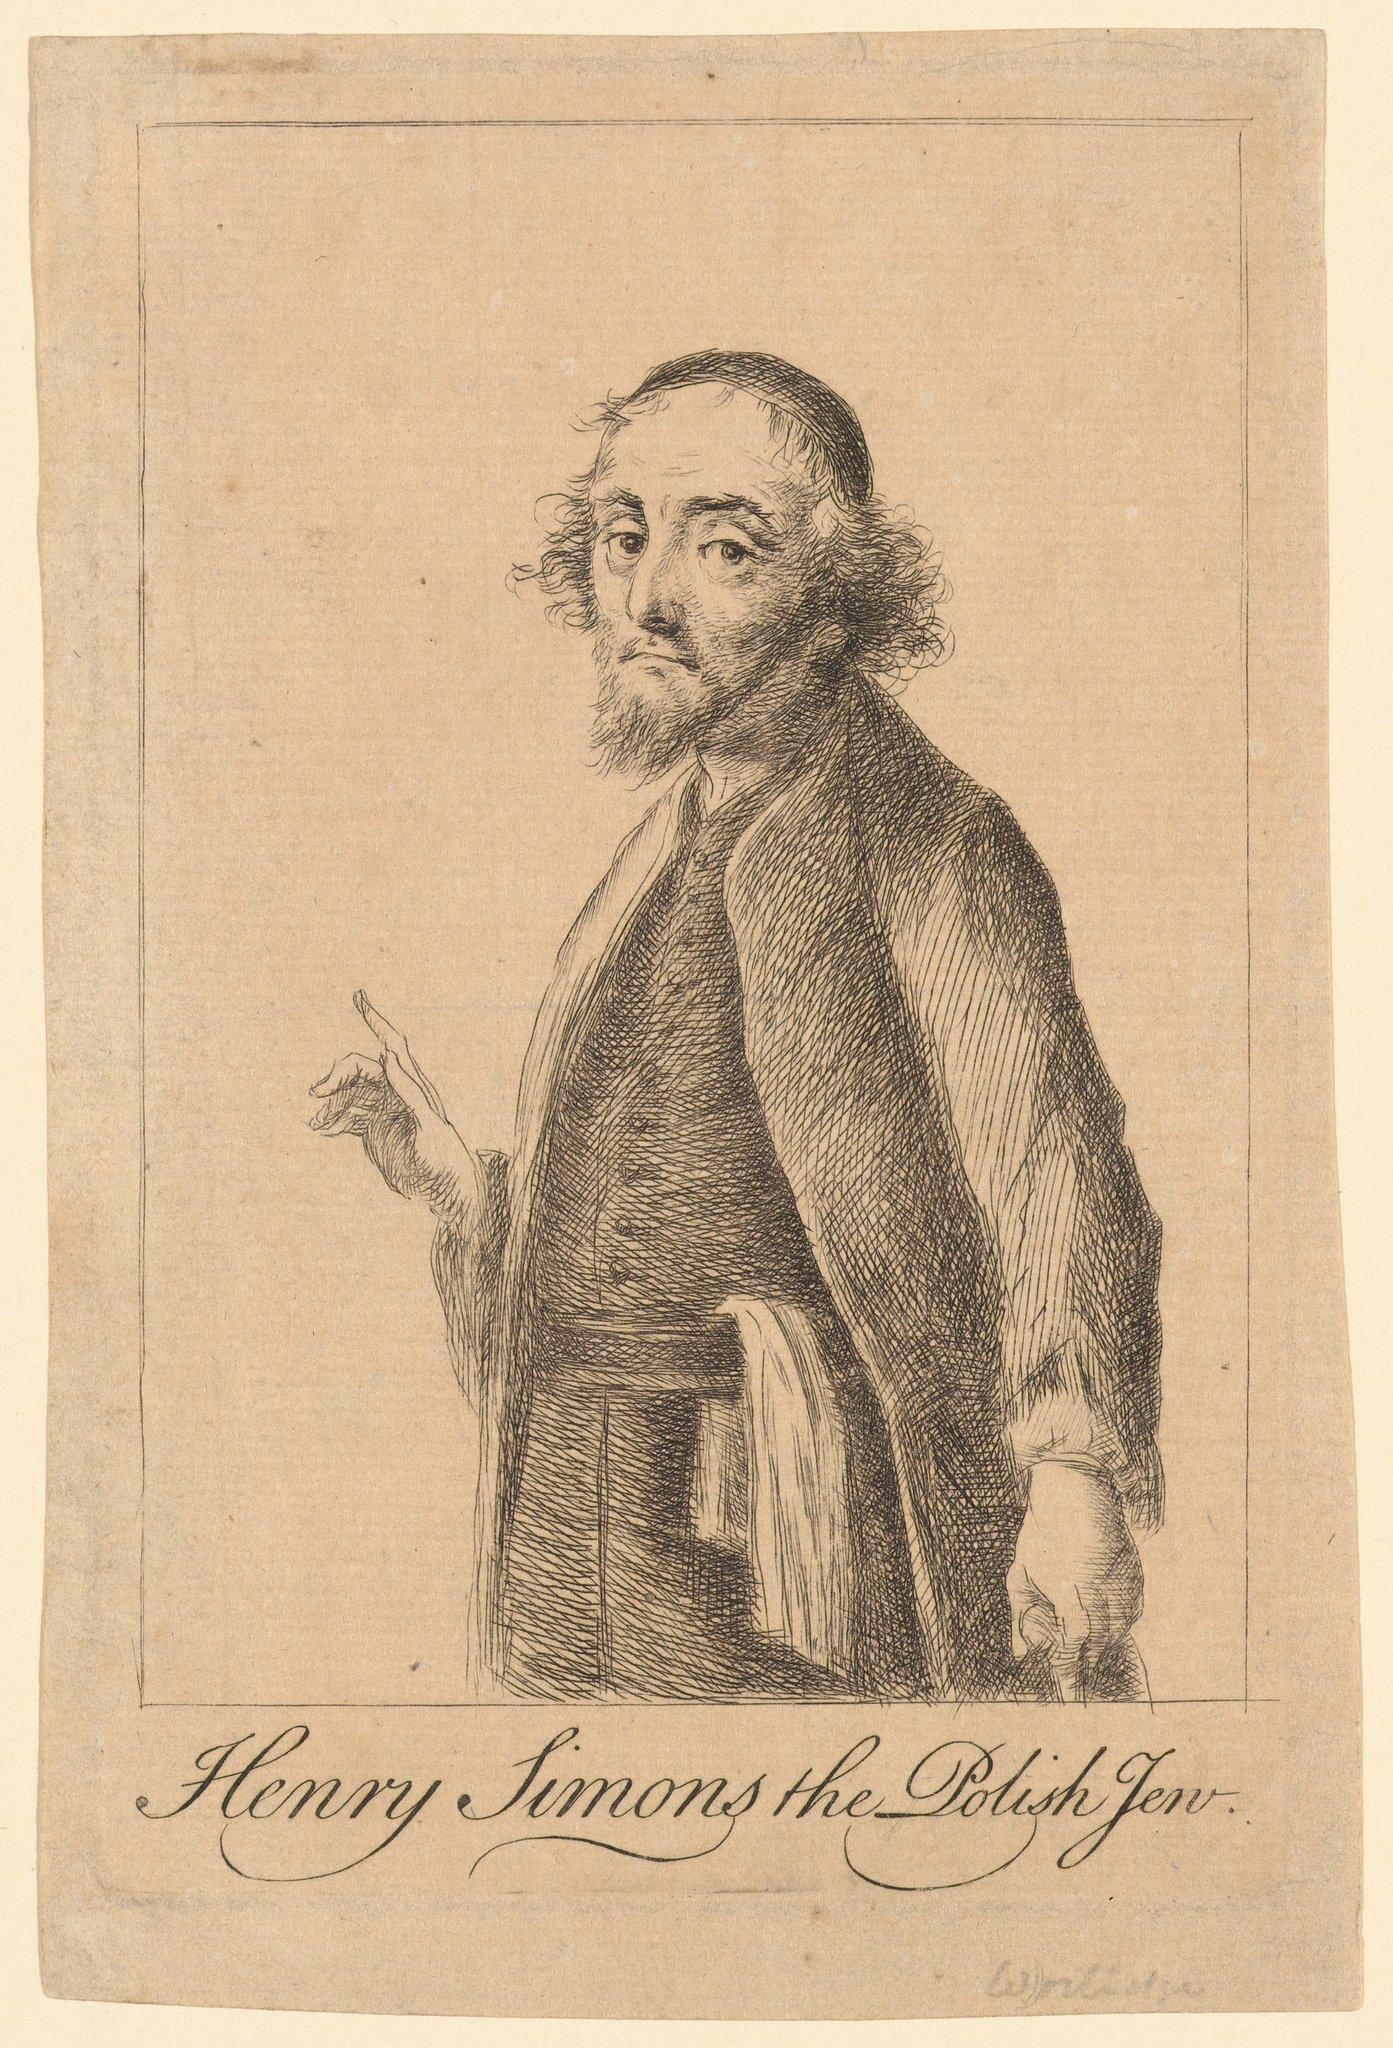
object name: print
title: Henry Simons the Polish Jew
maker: thomas worlidge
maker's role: artist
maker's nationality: british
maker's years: 1700-1766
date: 1753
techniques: etching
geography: england